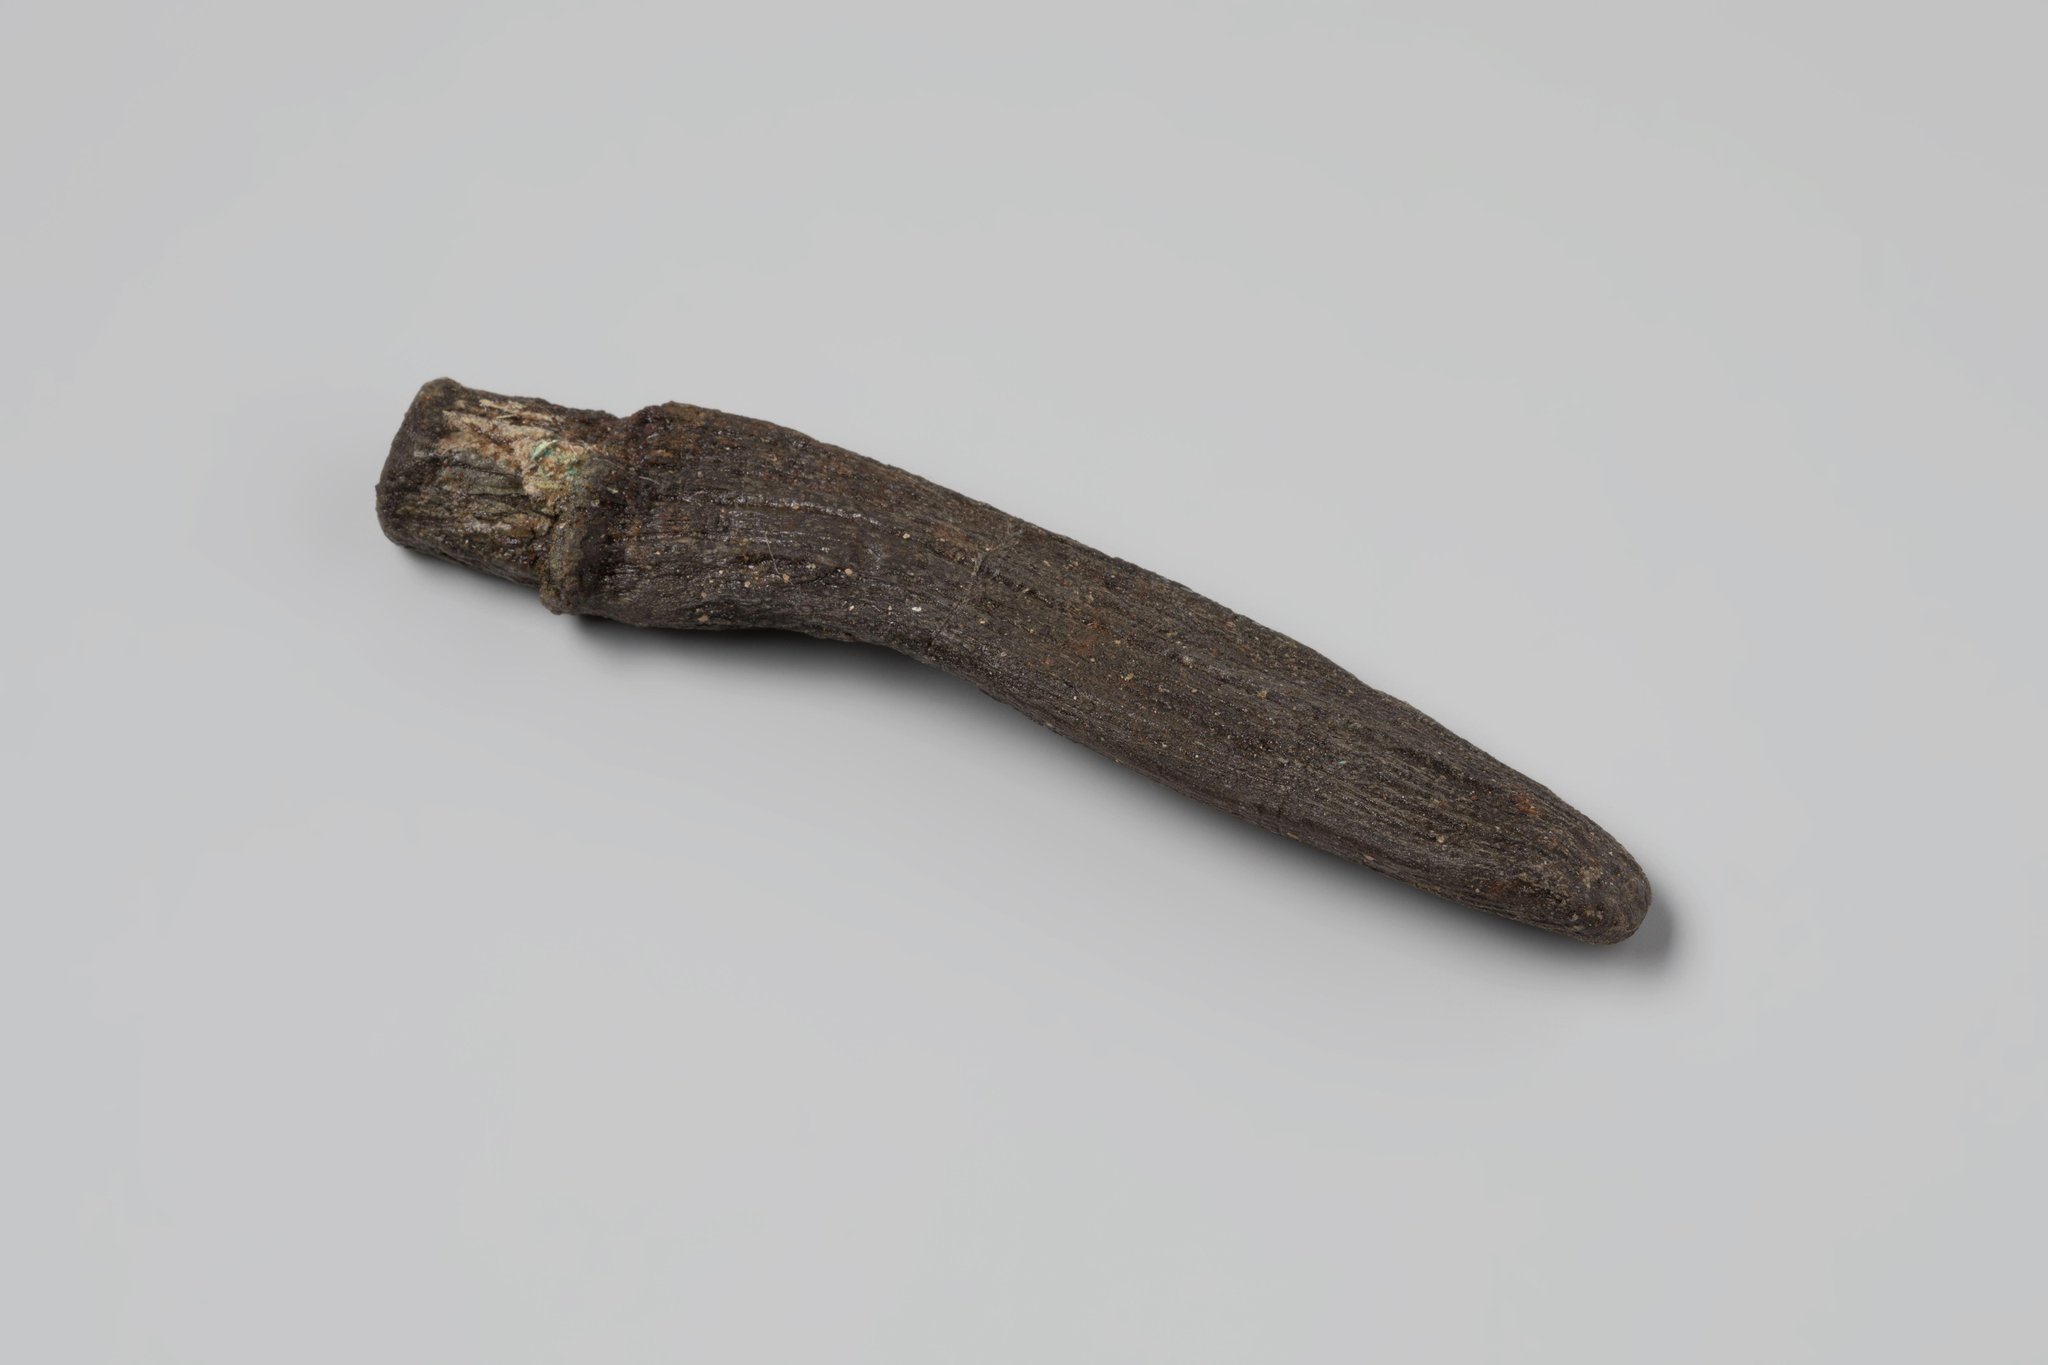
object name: tool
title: Handvat van gereedschap uit het wrak van de Oost-Indiëvaarder Hollandia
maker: Anonymous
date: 1700-1743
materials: wood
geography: netherlands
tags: verenigde oostindische compagnie, hollandia (schip), annet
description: Tools and instruments, various tools, unclassifiable tool handle; fragm, deformed: oblong, rounded upper end, narrowed lower end.